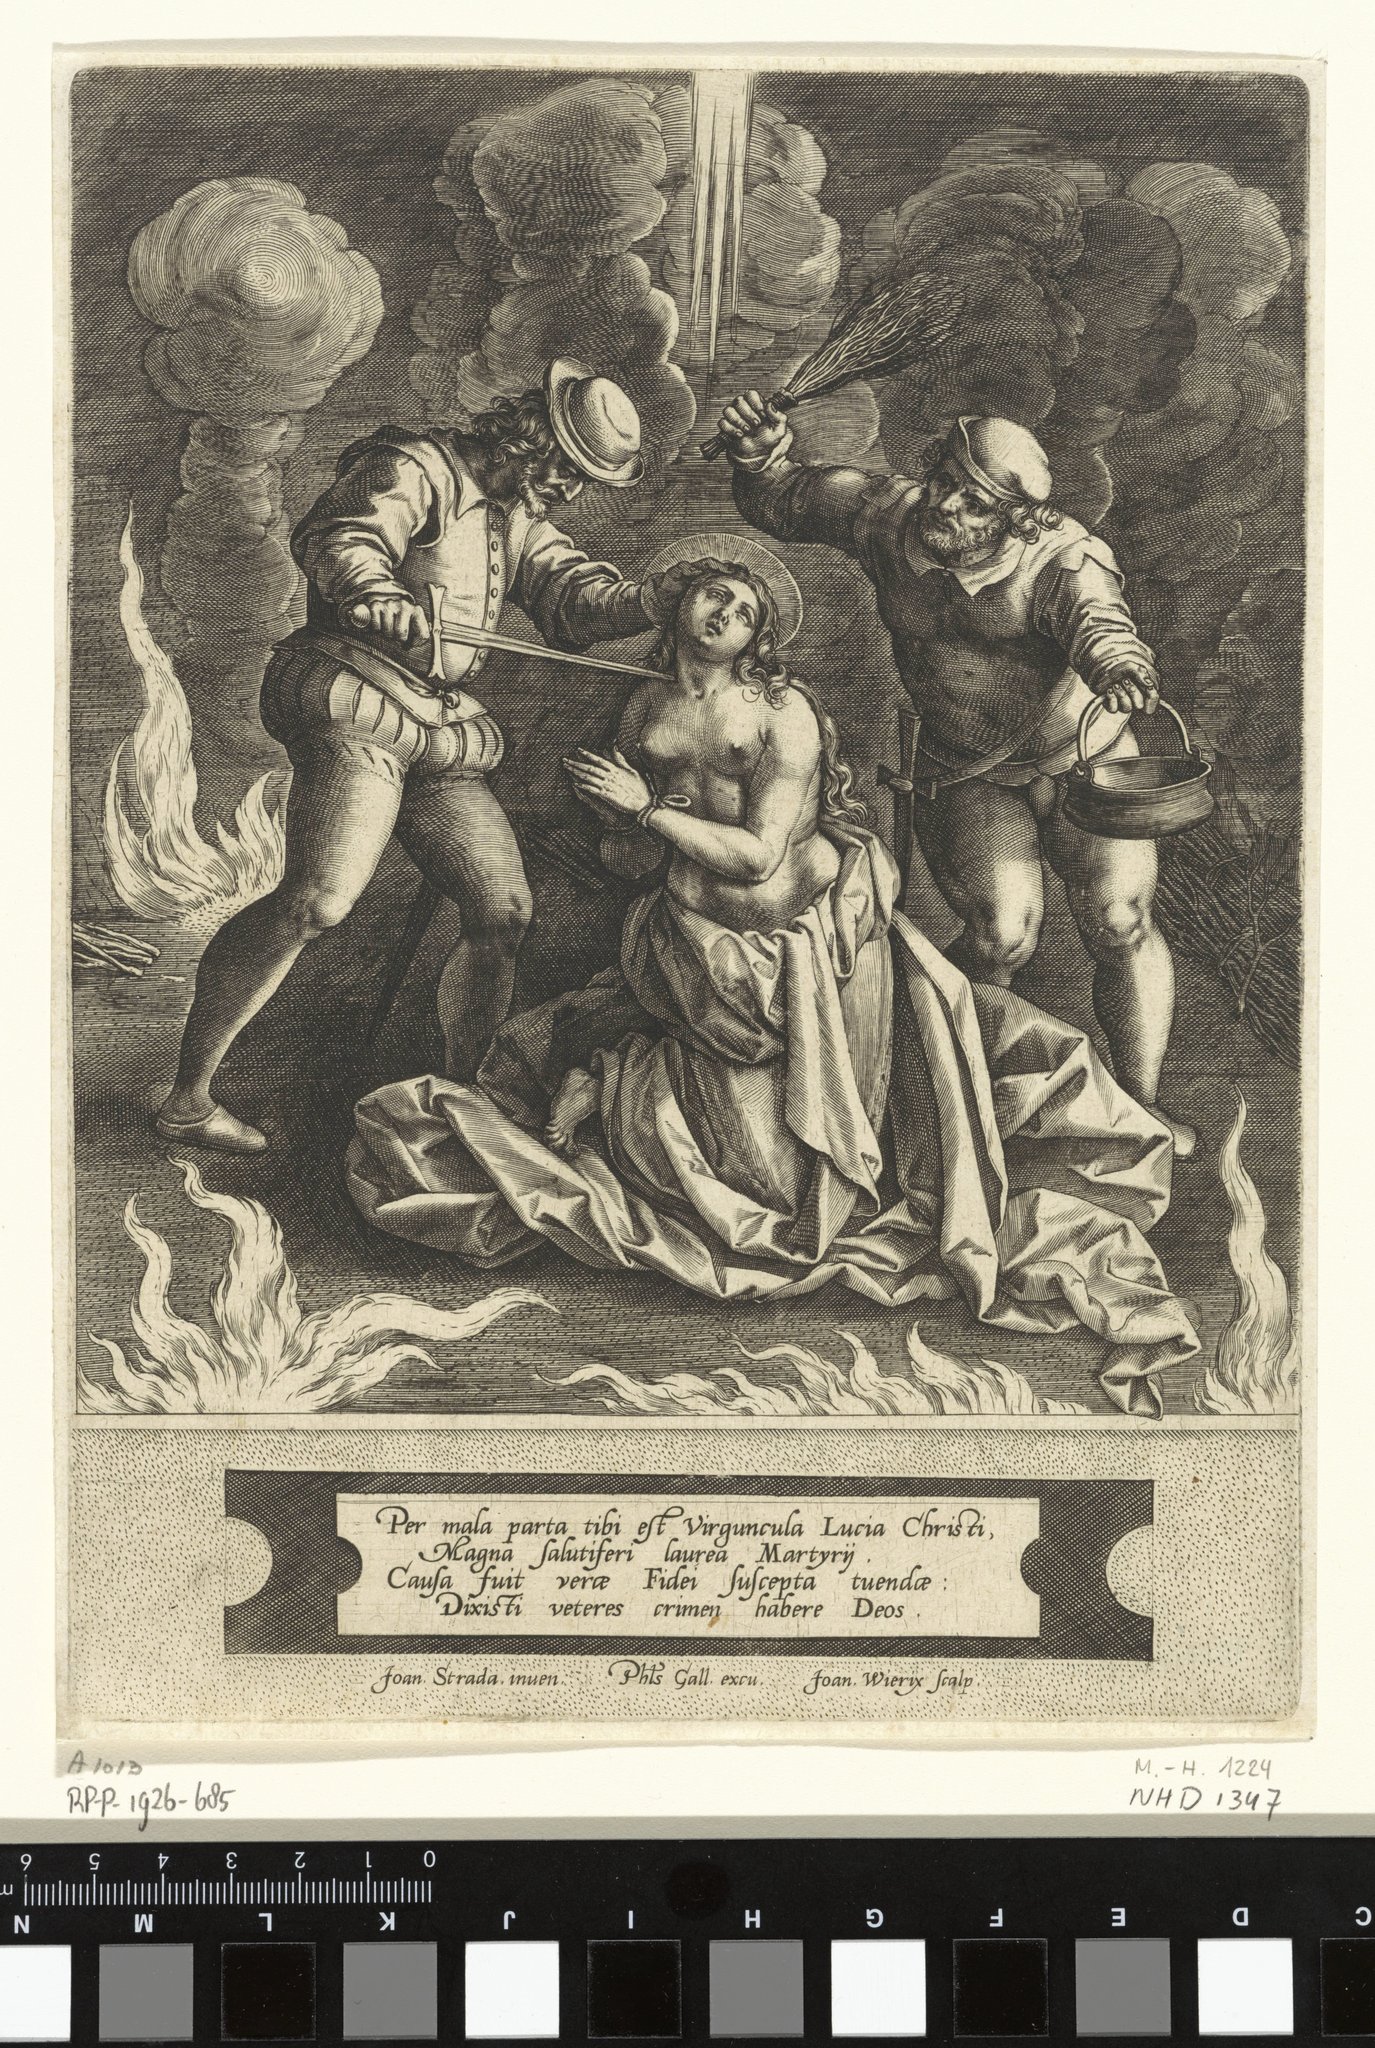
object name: print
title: Marteldood van H. Lucia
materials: paper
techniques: engraving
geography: antwerp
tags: st. lucy is stabbed through the throat with a dagger or a sword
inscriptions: collector's mark: Lugt 2166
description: De heilige Lucia wordt door een soldaat gedood met een dolkstoot in haar keel. Door een andere man wordt ze gegeseld. Rond hen branden vuren. Vanuit de hemel dalen stralen op haar neer. In het kader in de marge een vierregelig onderschrift in het Latijn.